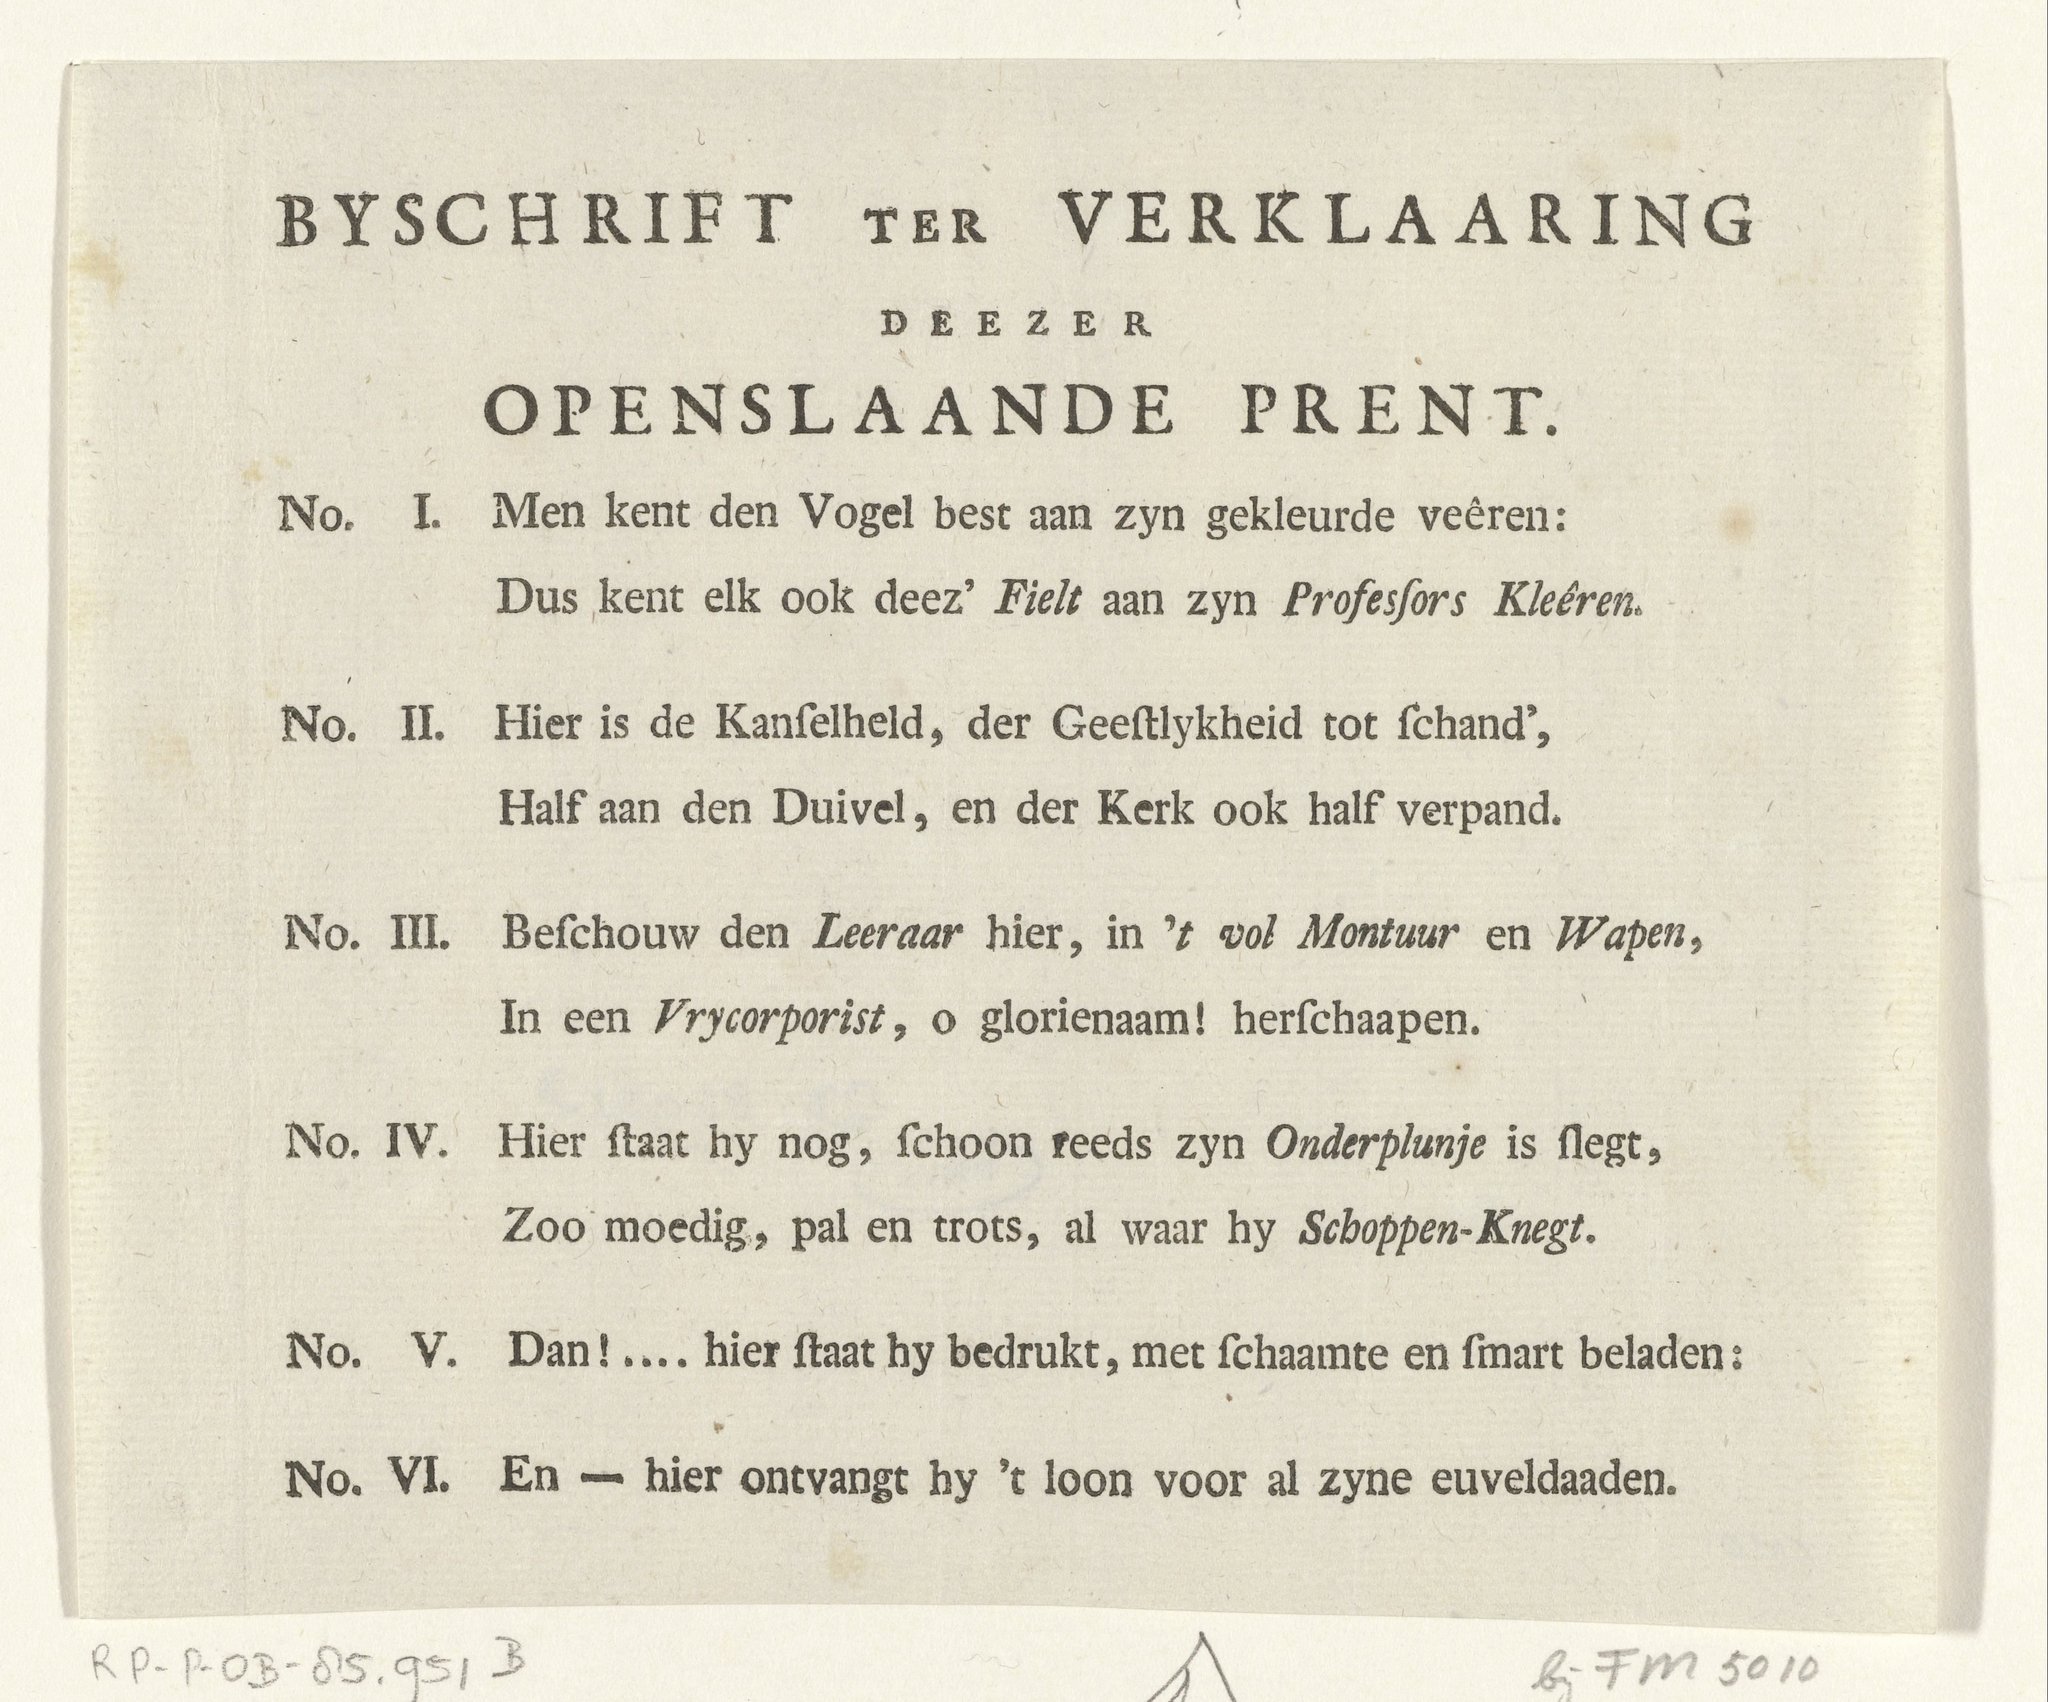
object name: text sheet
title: Tekstblad bij de spotprent op Johan Jacob le Sage ten Broek, 1787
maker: Anonymous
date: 1787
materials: paper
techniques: letterpress printing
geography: northern netherlands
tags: the hague, rotterdam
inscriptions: collector's mark: Lugt 2228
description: Tekstblad bij de spotprent op de, na het herstel van de prins van Oranje, door het Rotterdamse stadsbestuur ontslagen patriotse predikant Johan Jacob le Sage ten Broek, oktober 1787. Tweeregelige versjes genummerd I-VI.